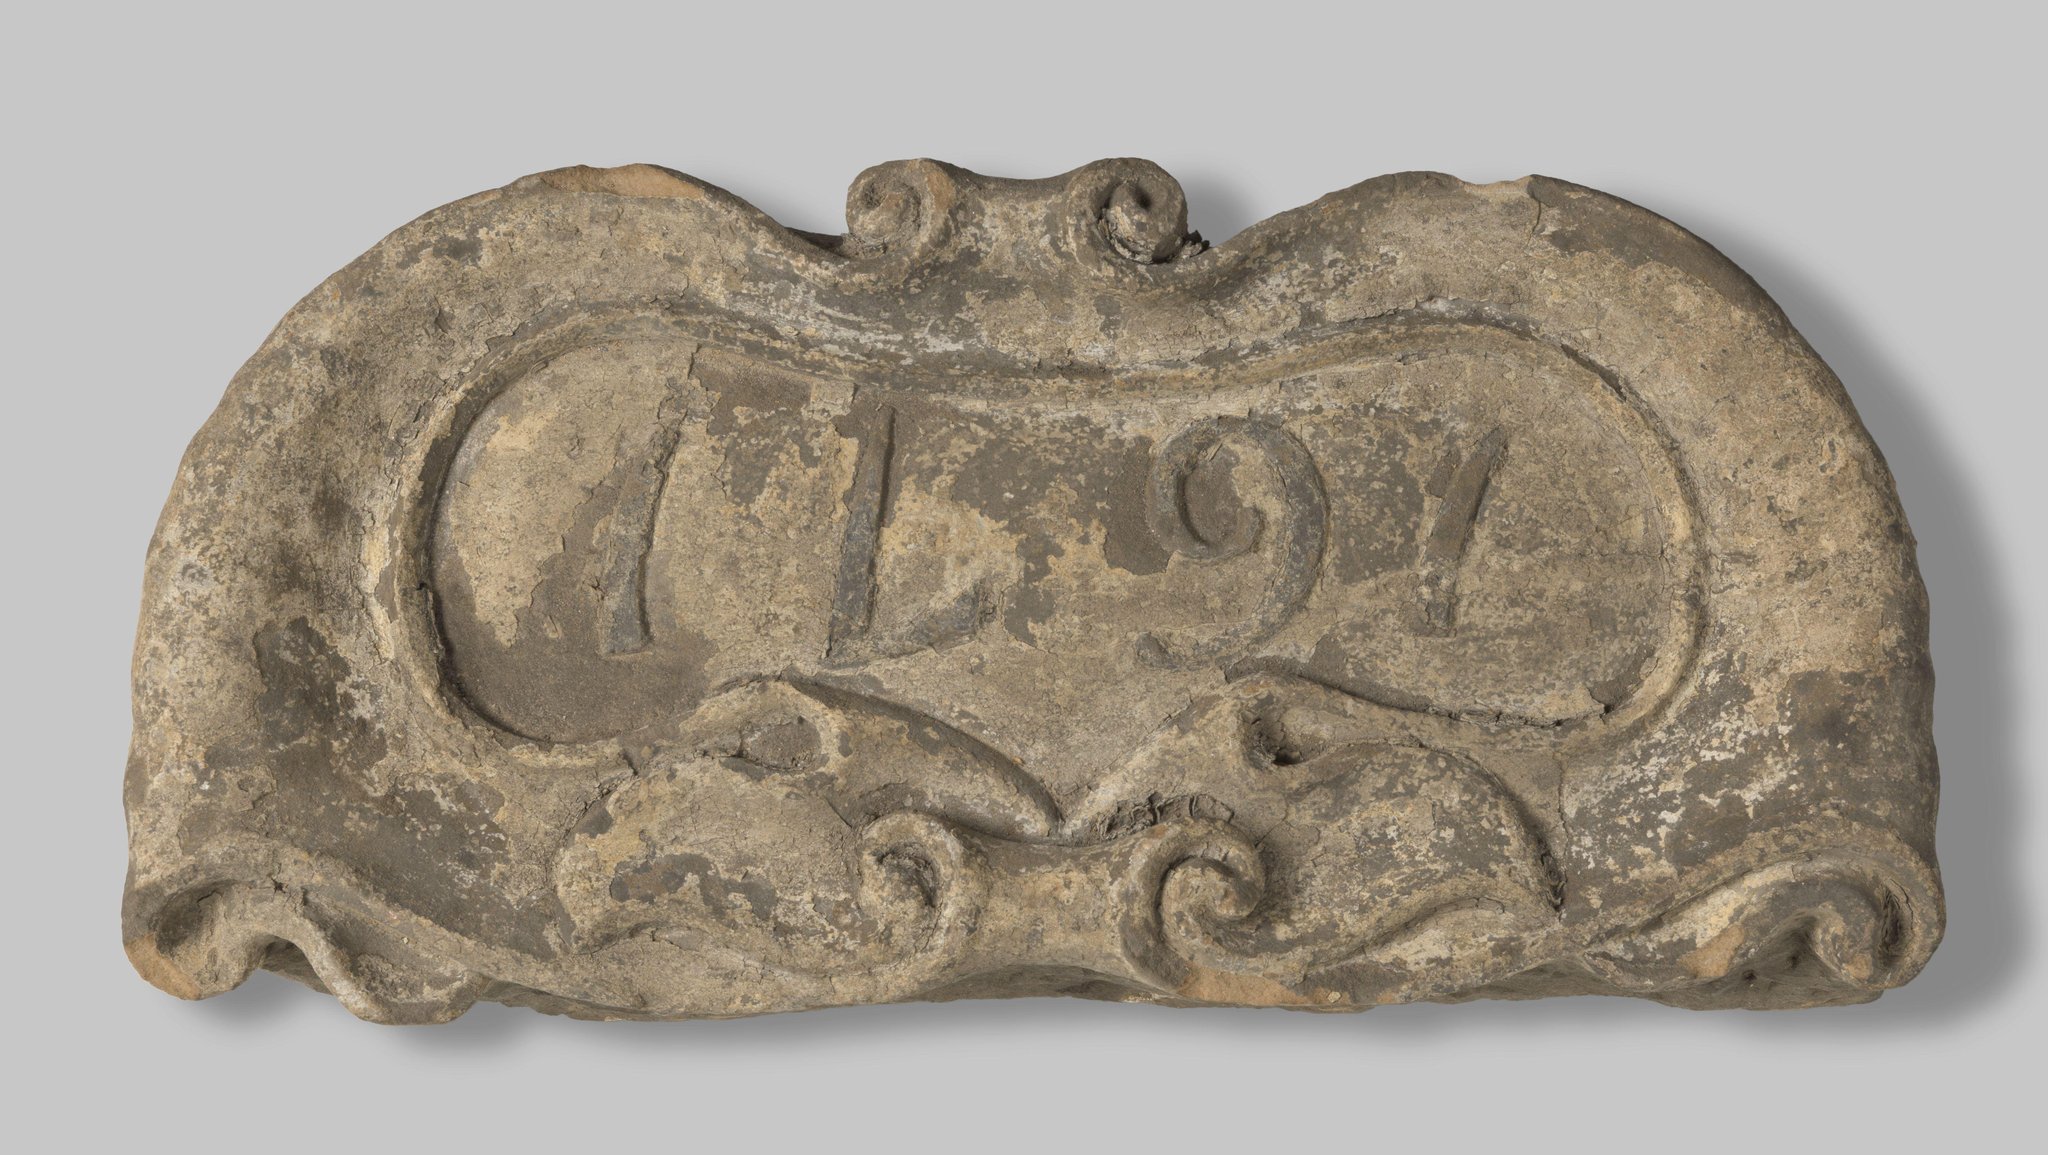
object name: gable stone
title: Gevelsteen met jaartal 1617.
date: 1671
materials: stone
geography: netherlands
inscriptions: date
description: Cartouche met voluten en rolwerk, waarbinnen het jaartal 1671.